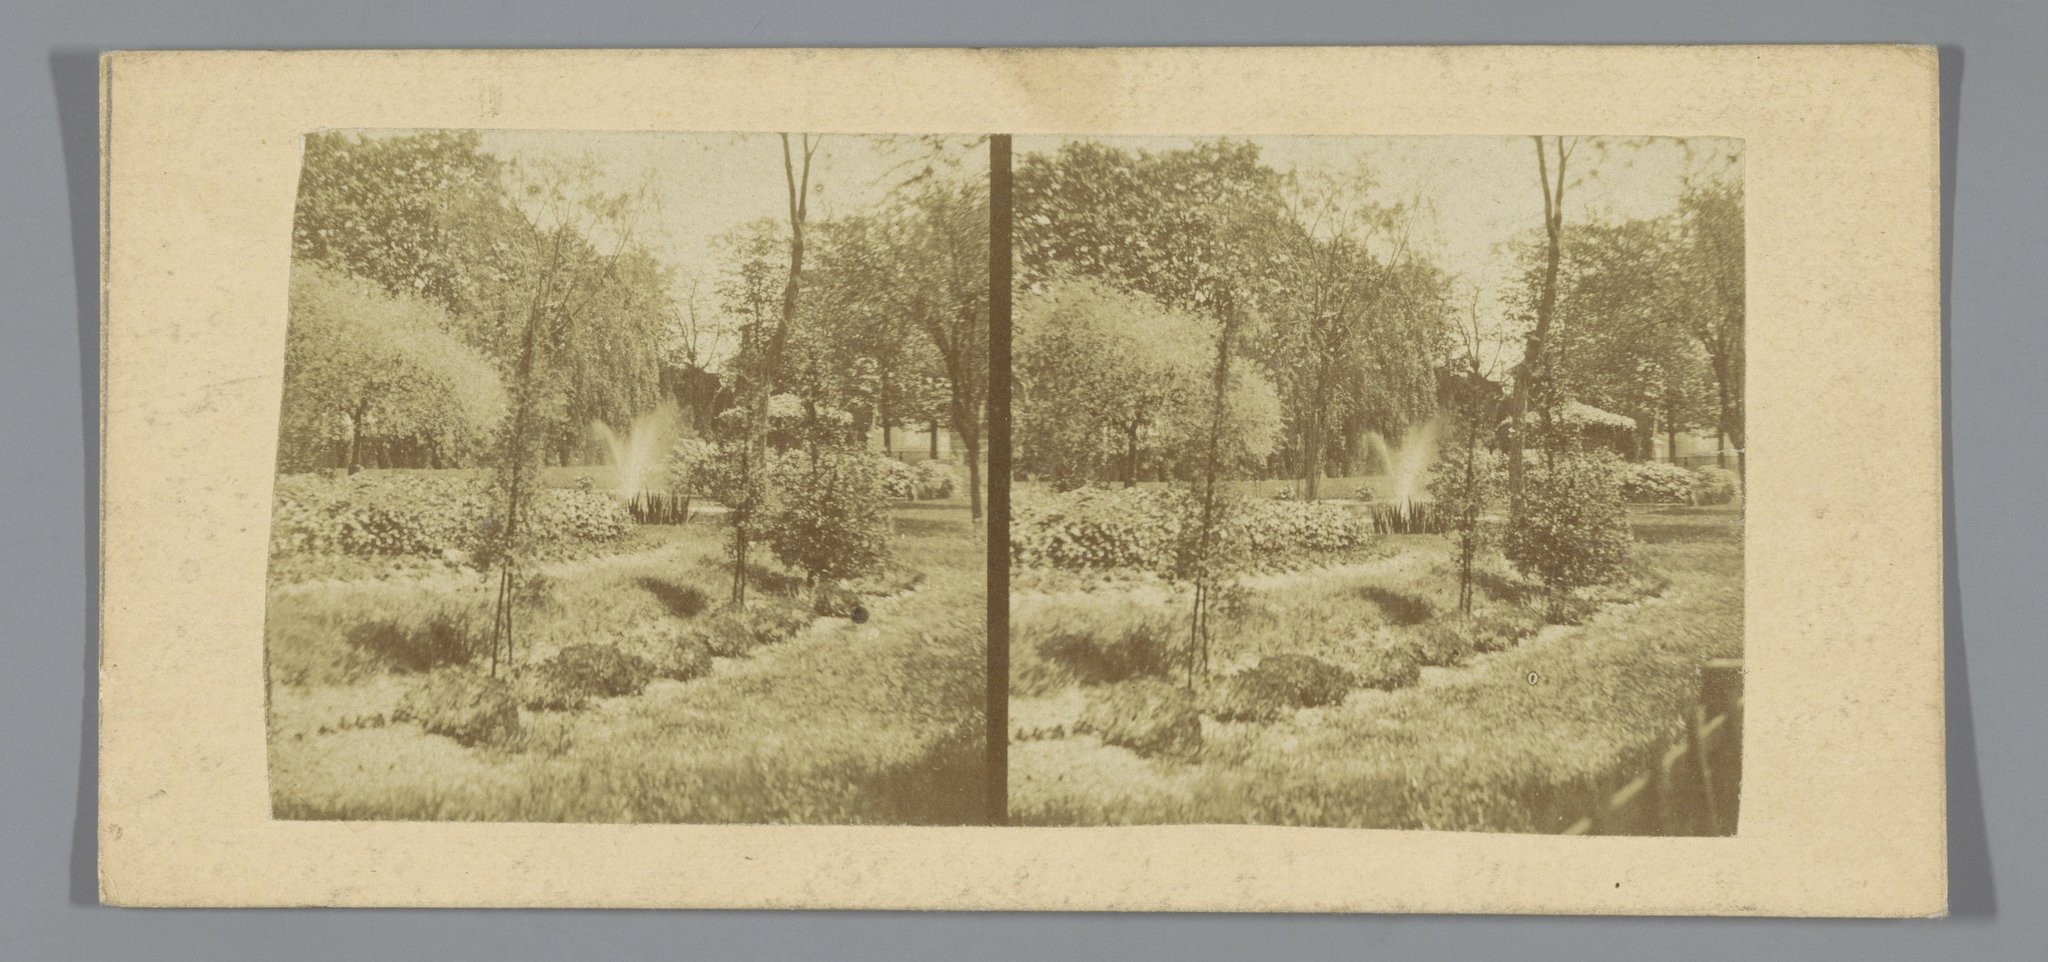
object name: stereograph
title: Tuin met fontein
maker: Anonymous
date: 1852-1858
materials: cardboard, paper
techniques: albumen print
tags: garden, garden fountain